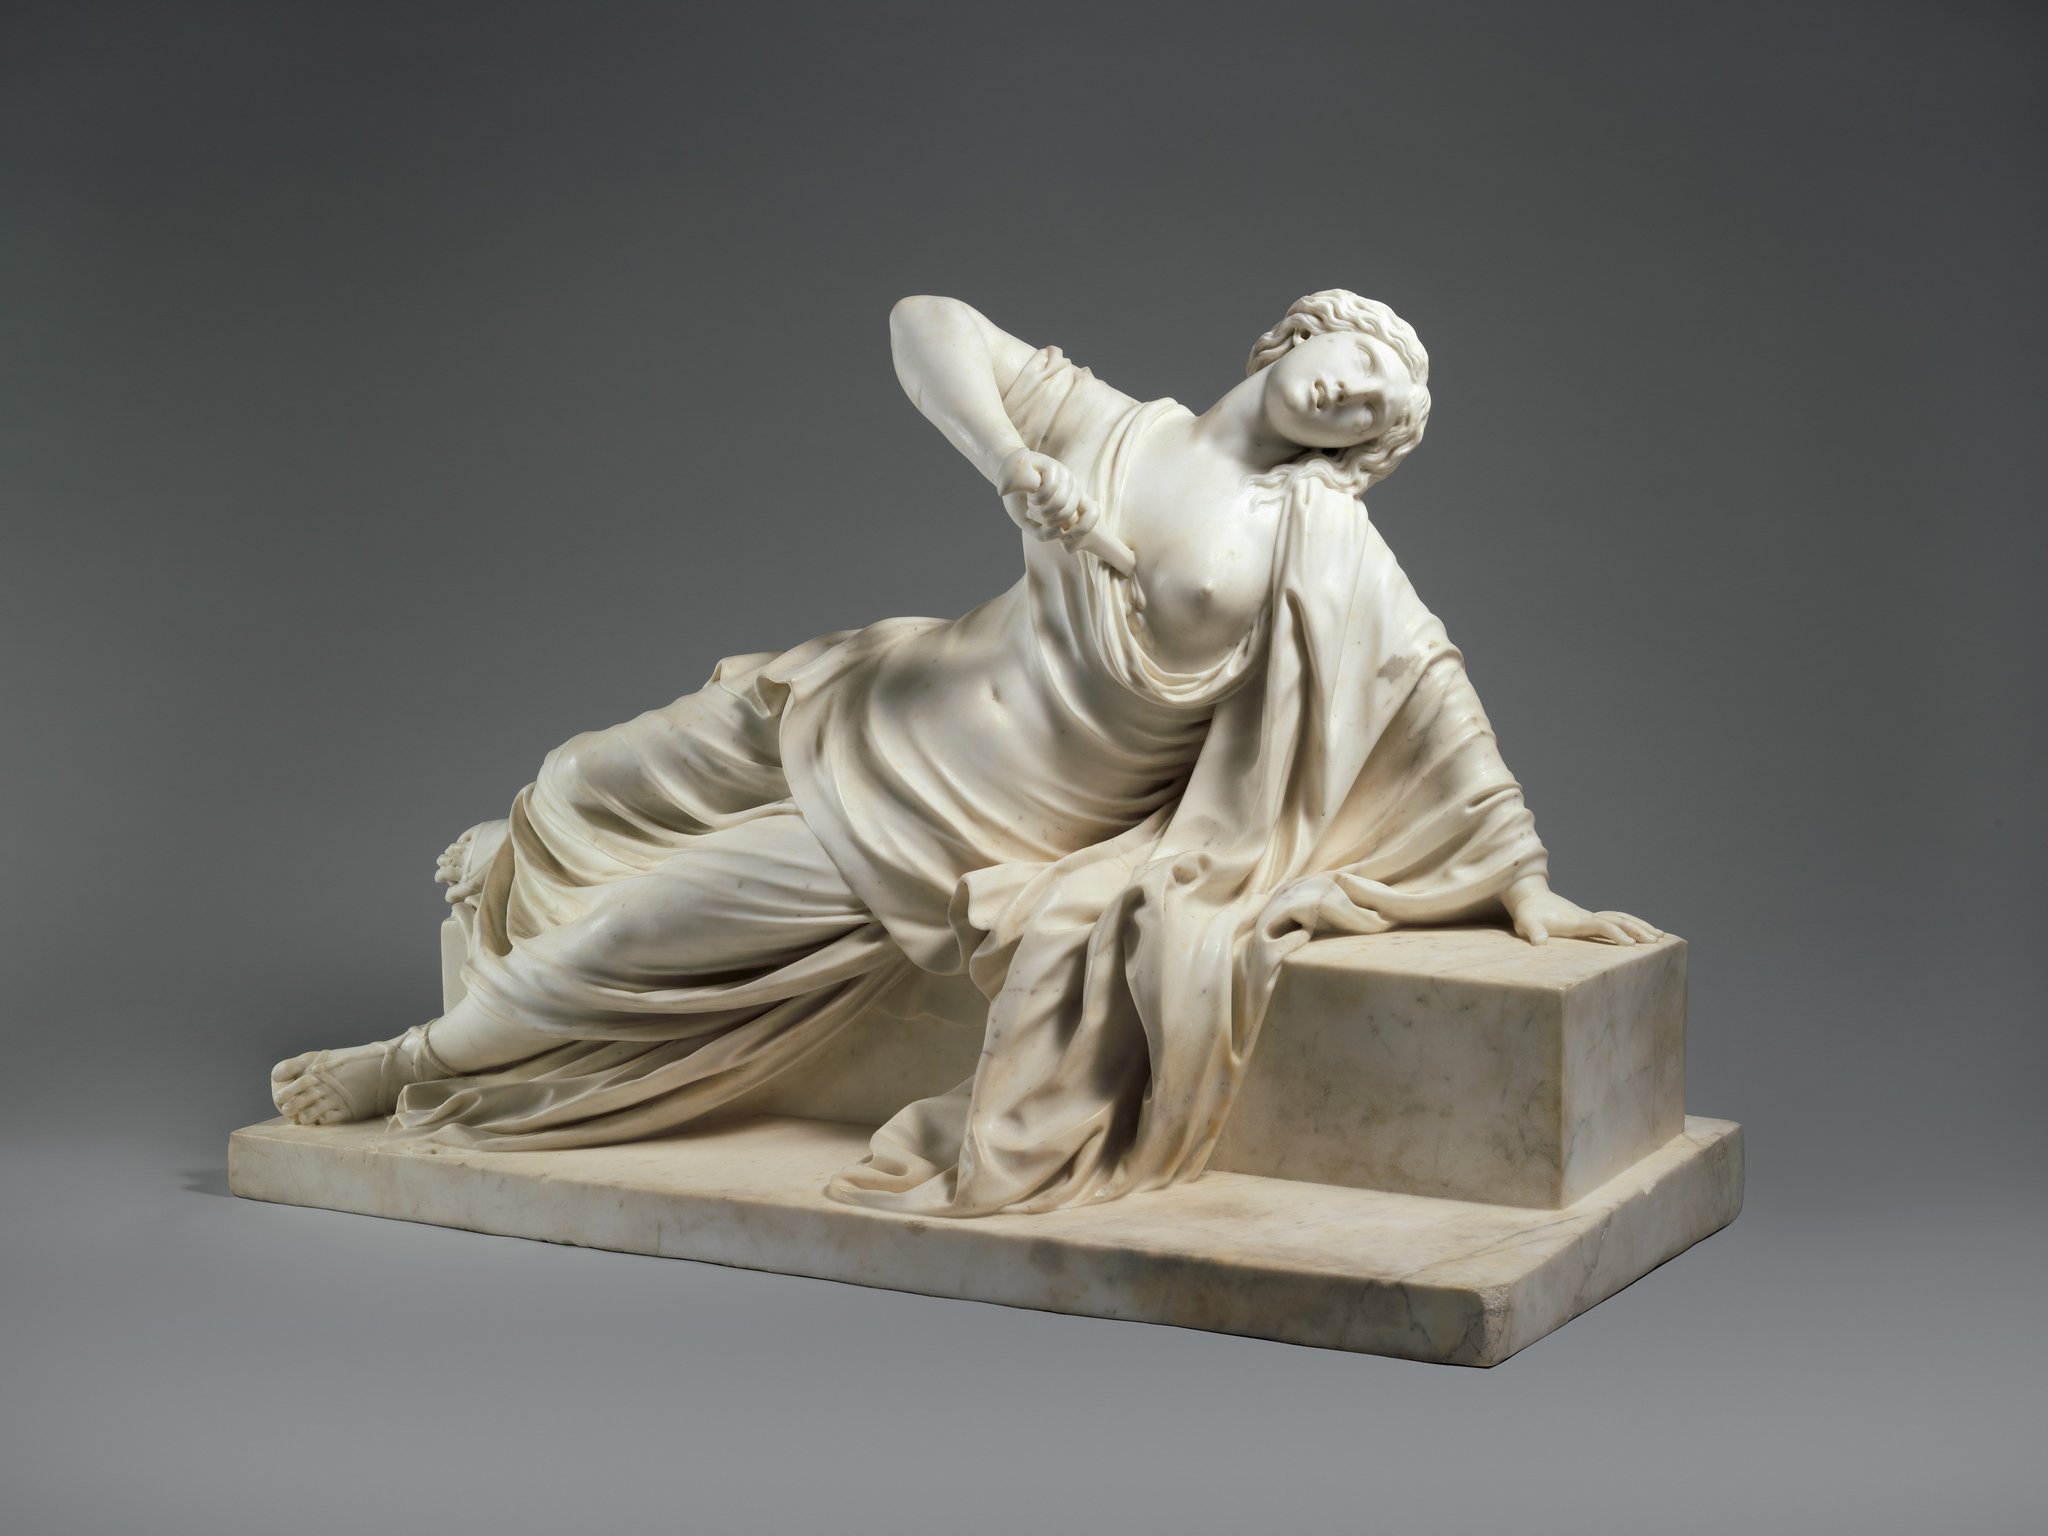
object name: statue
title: Lucretia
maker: philippe bertrand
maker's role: artist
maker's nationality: french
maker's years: 1663-1724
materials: marble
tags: women